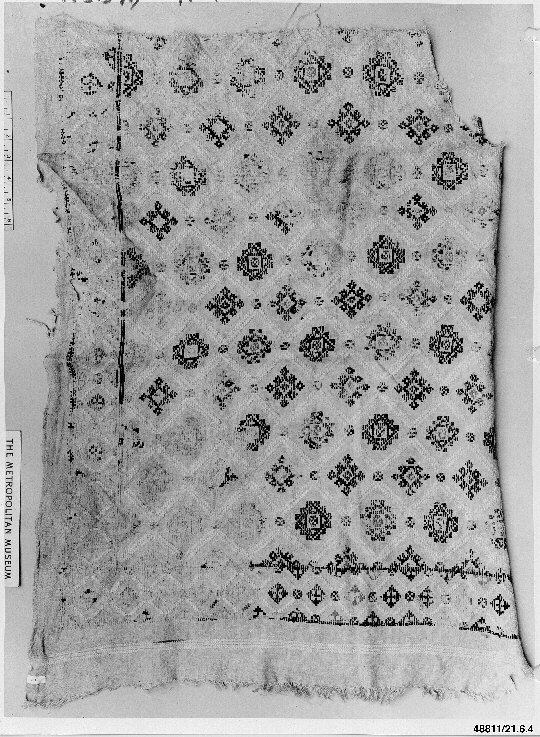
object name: fragment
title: Textile Fragment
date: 901-1100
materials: linen, wool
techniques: embroidery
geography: egypt